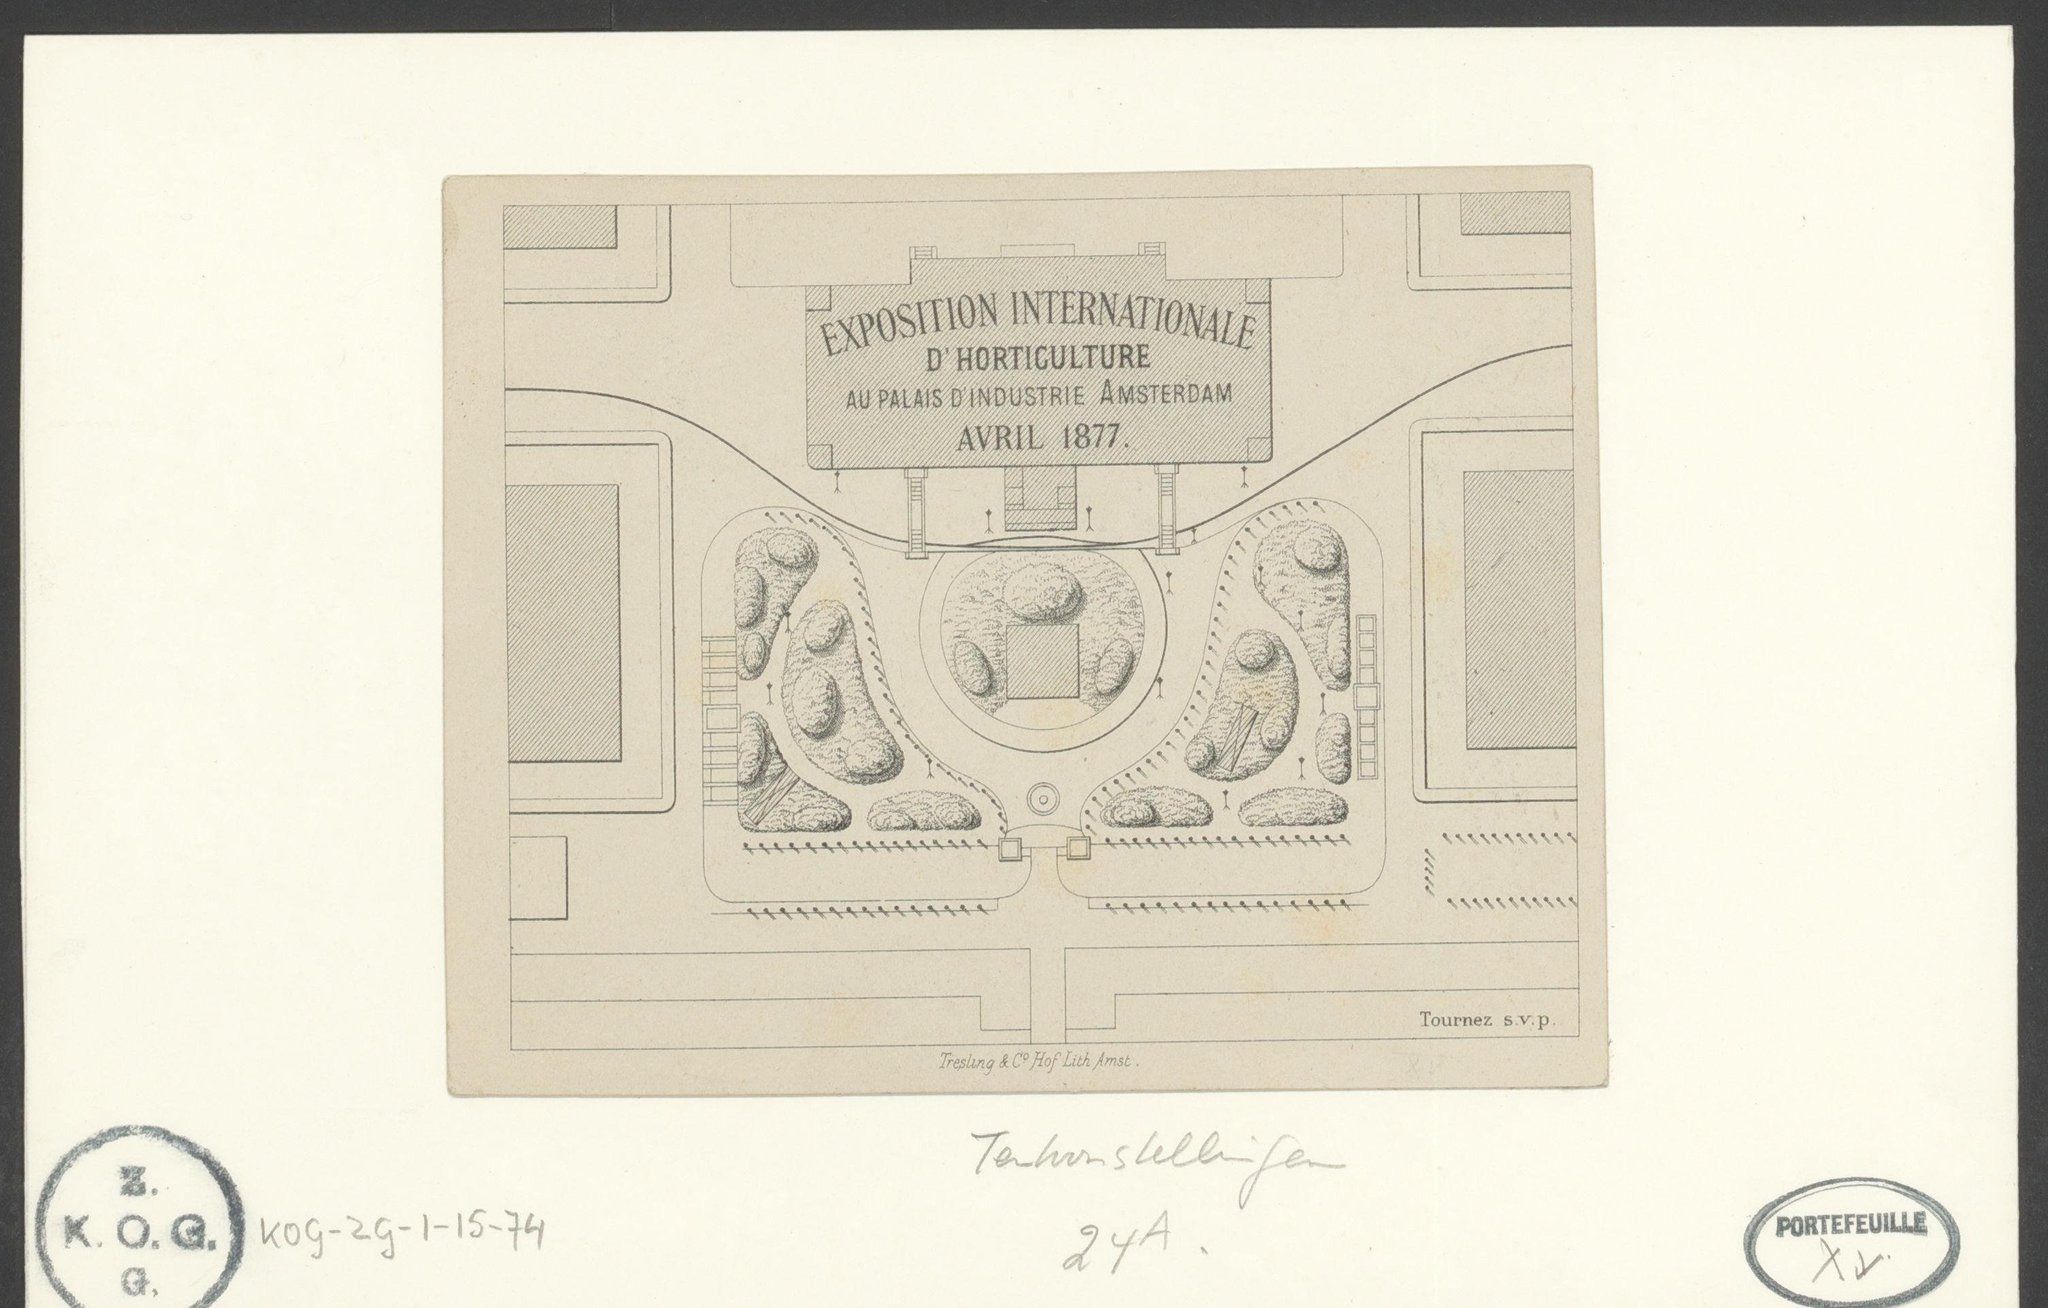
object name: print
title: Plattegrond van de Internationale tentoonstelling van tuinbouw in Amsterdam, april 1877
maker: Anonymous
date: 1877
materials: paper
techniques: lithograph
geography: amsterdam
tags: trade exhibition, industries fair, maps, atlases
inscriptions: collector's mark: Lugt 1641, stamp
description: Onderwerpsrubrieken binnen de Atlas Zeden en Gewoonten: Handel, nijverheid en verkeer, Tentoonstellingen.